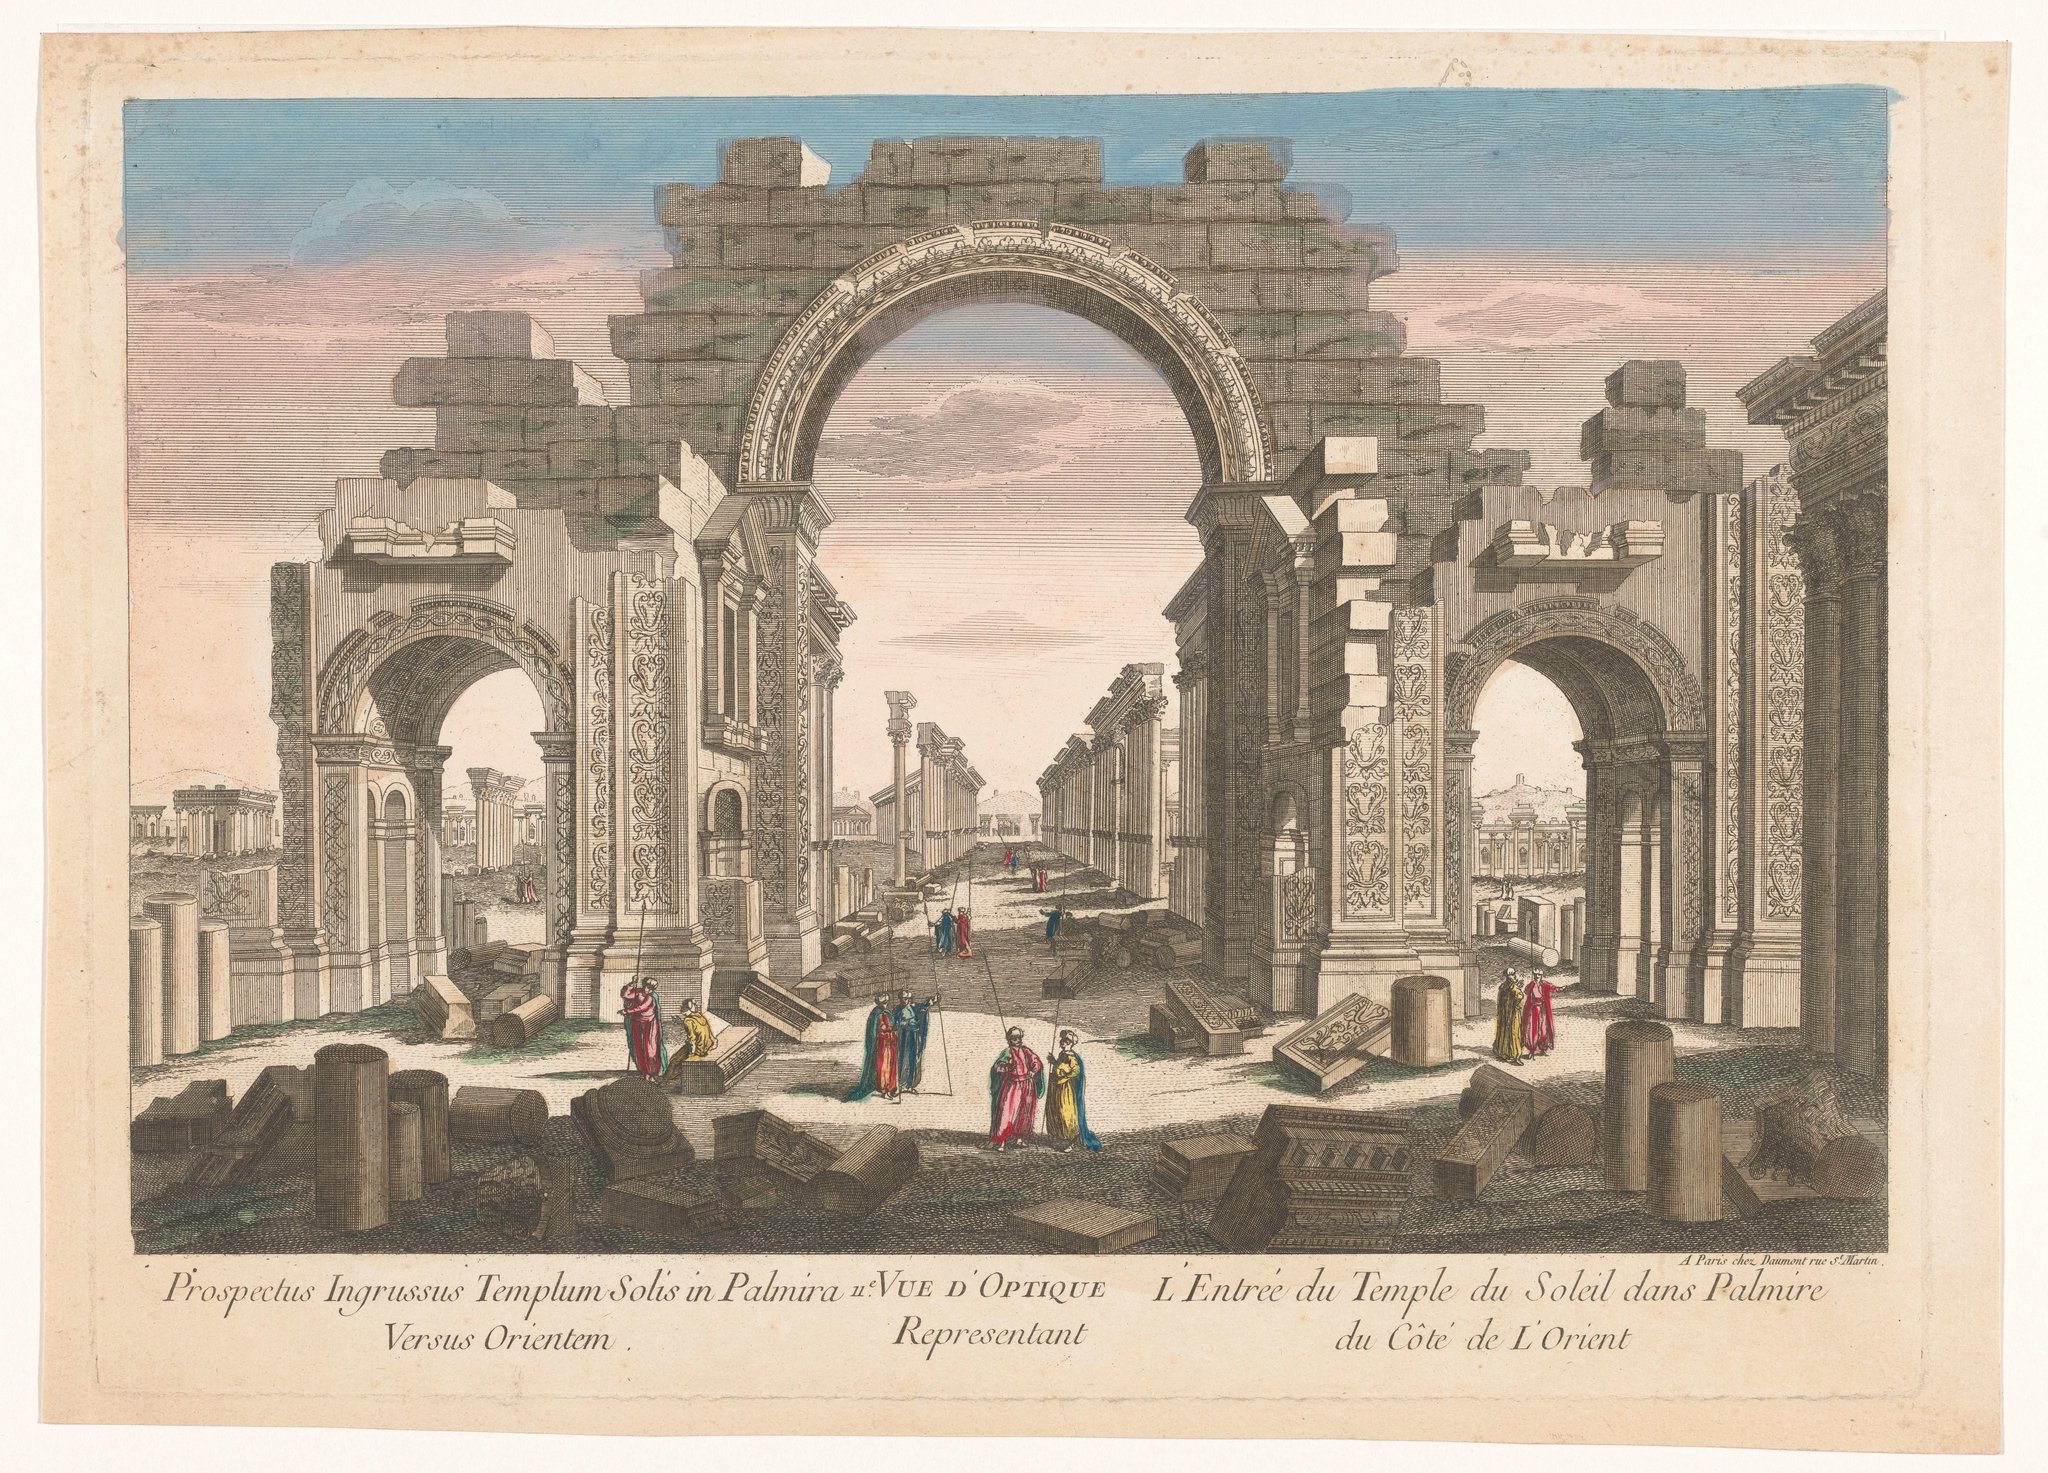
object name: opticaprent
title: 11e. Vue d'optique representant l'entrée du temple du soleil dans Palmire du côté de l'orient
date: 1745-1775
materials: paper, watercolor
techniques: brush, etching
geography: paris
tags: colonnade, arch, archivolt ~ architecture, landscape with ruins (+ city(-scape) with figures, staffage)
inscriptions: watermark, collector's mark: Lugt 2233